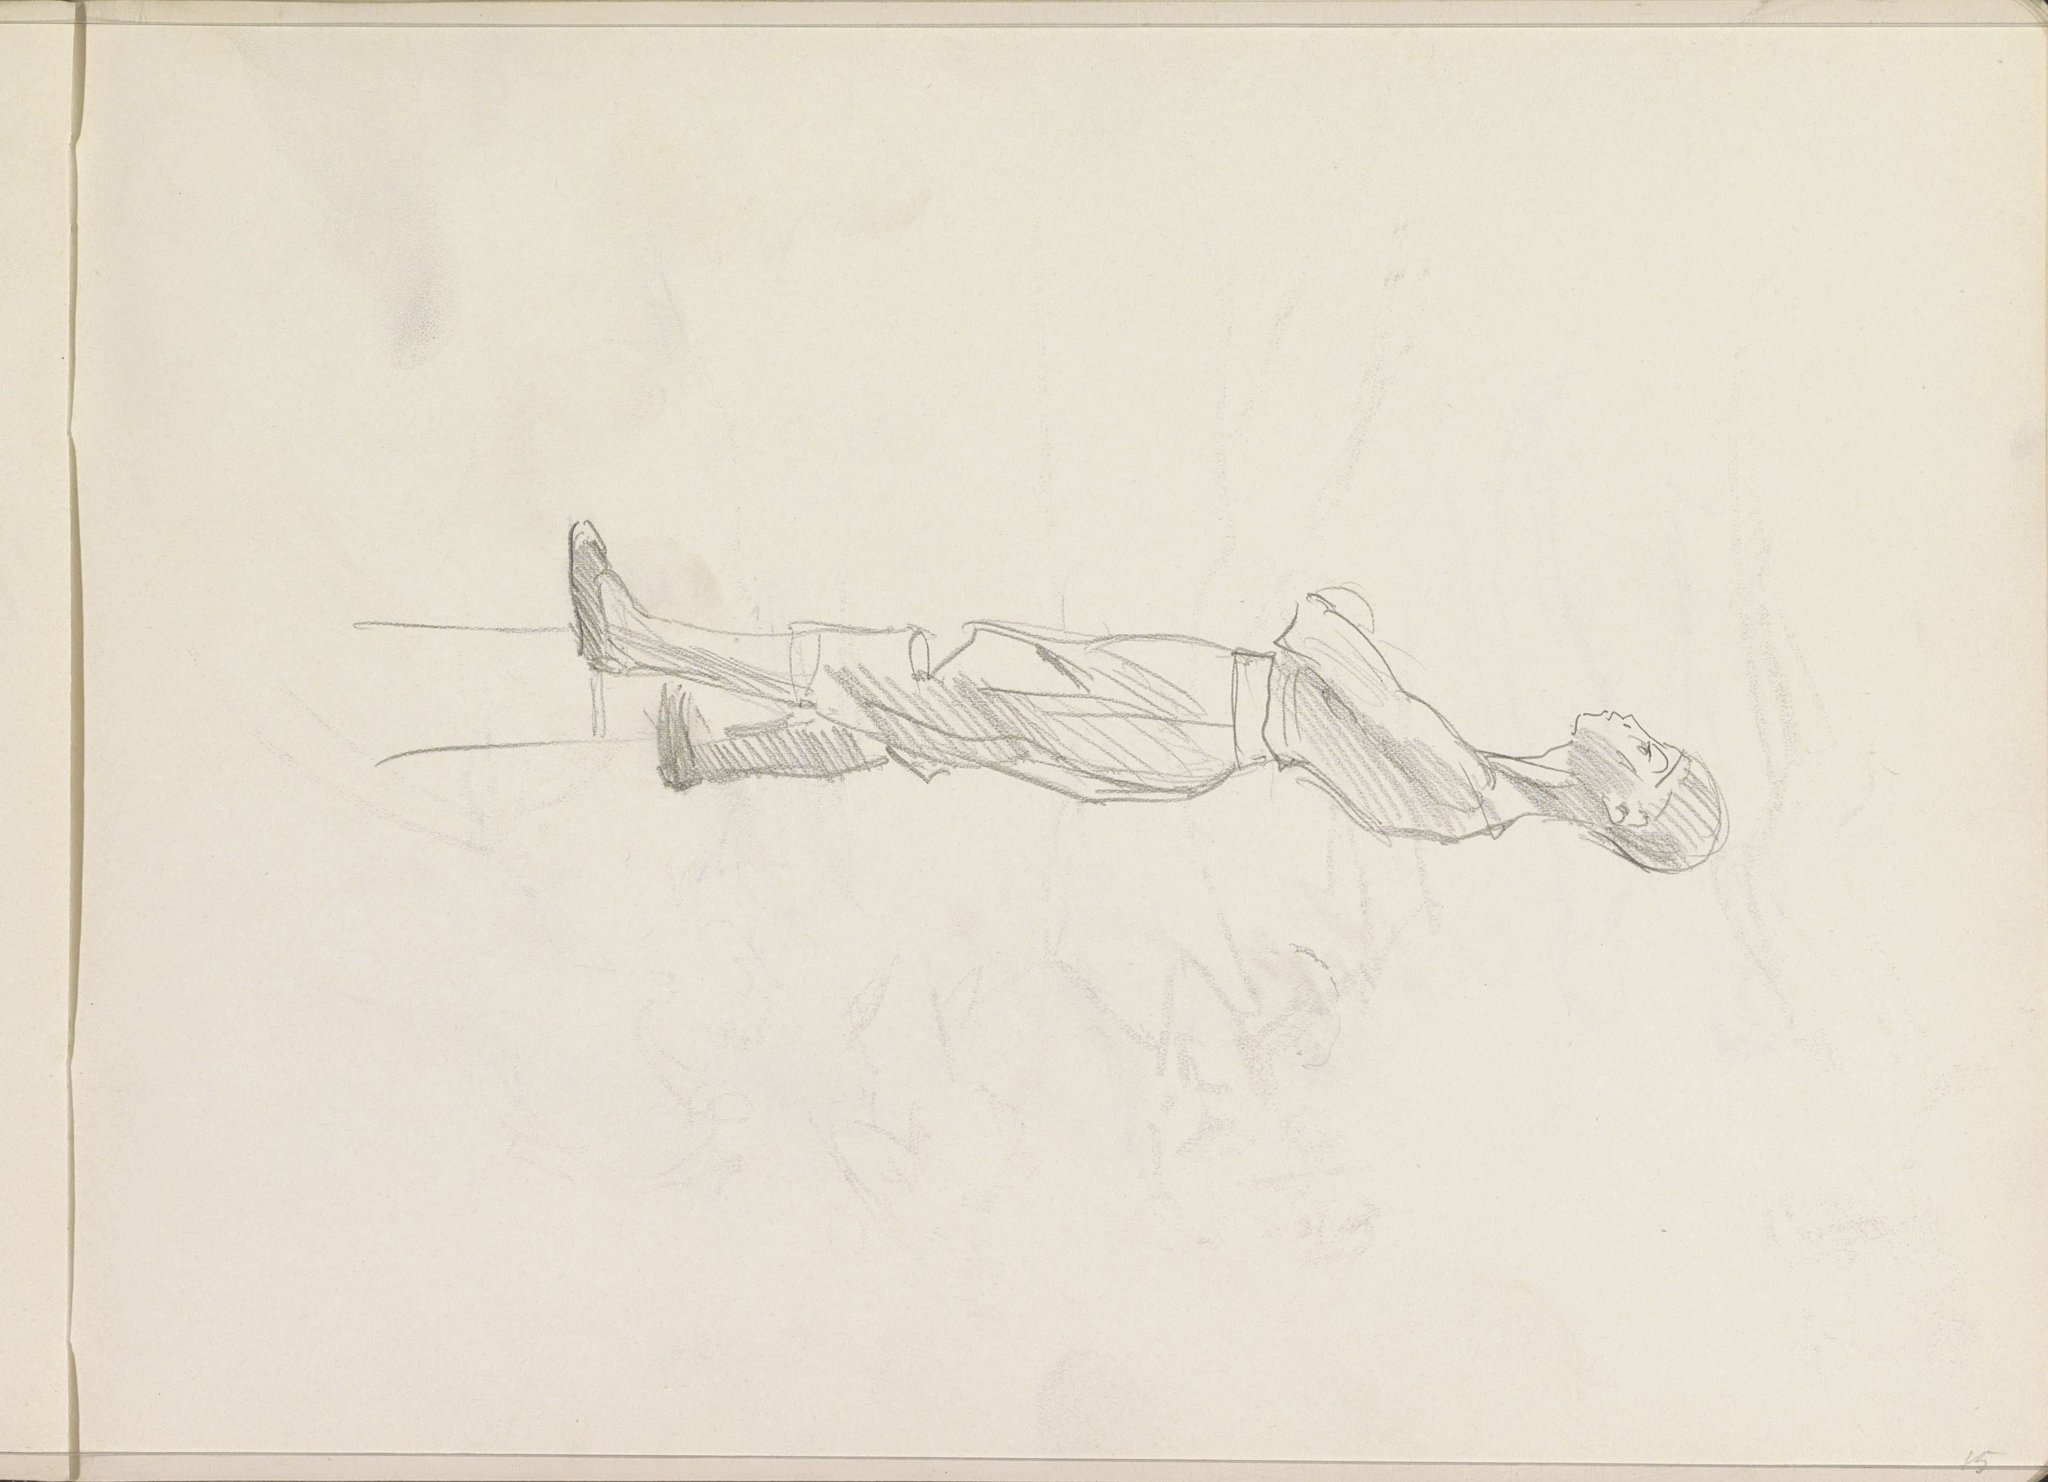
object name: sketchbook leaf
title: Staande jonge man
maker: isaac israels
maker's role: draughtsman, painter, print maker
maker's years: 1865-1934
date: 1875-1934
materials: paper, pencil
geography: the hague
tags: youth, adolescent (+ standing)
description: Met zijn armen over elkaar. Blad 15 recto uit schetsboek V met 33 bladen.